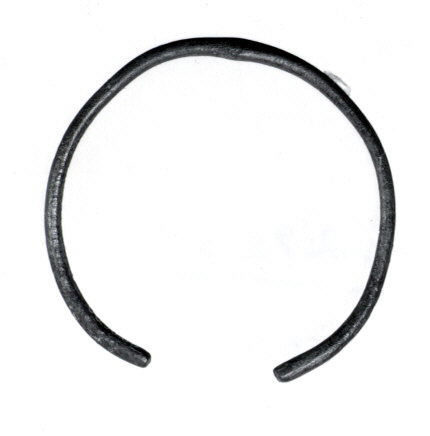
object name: bracelet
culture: sasanian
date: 201-700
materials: copper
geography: iran